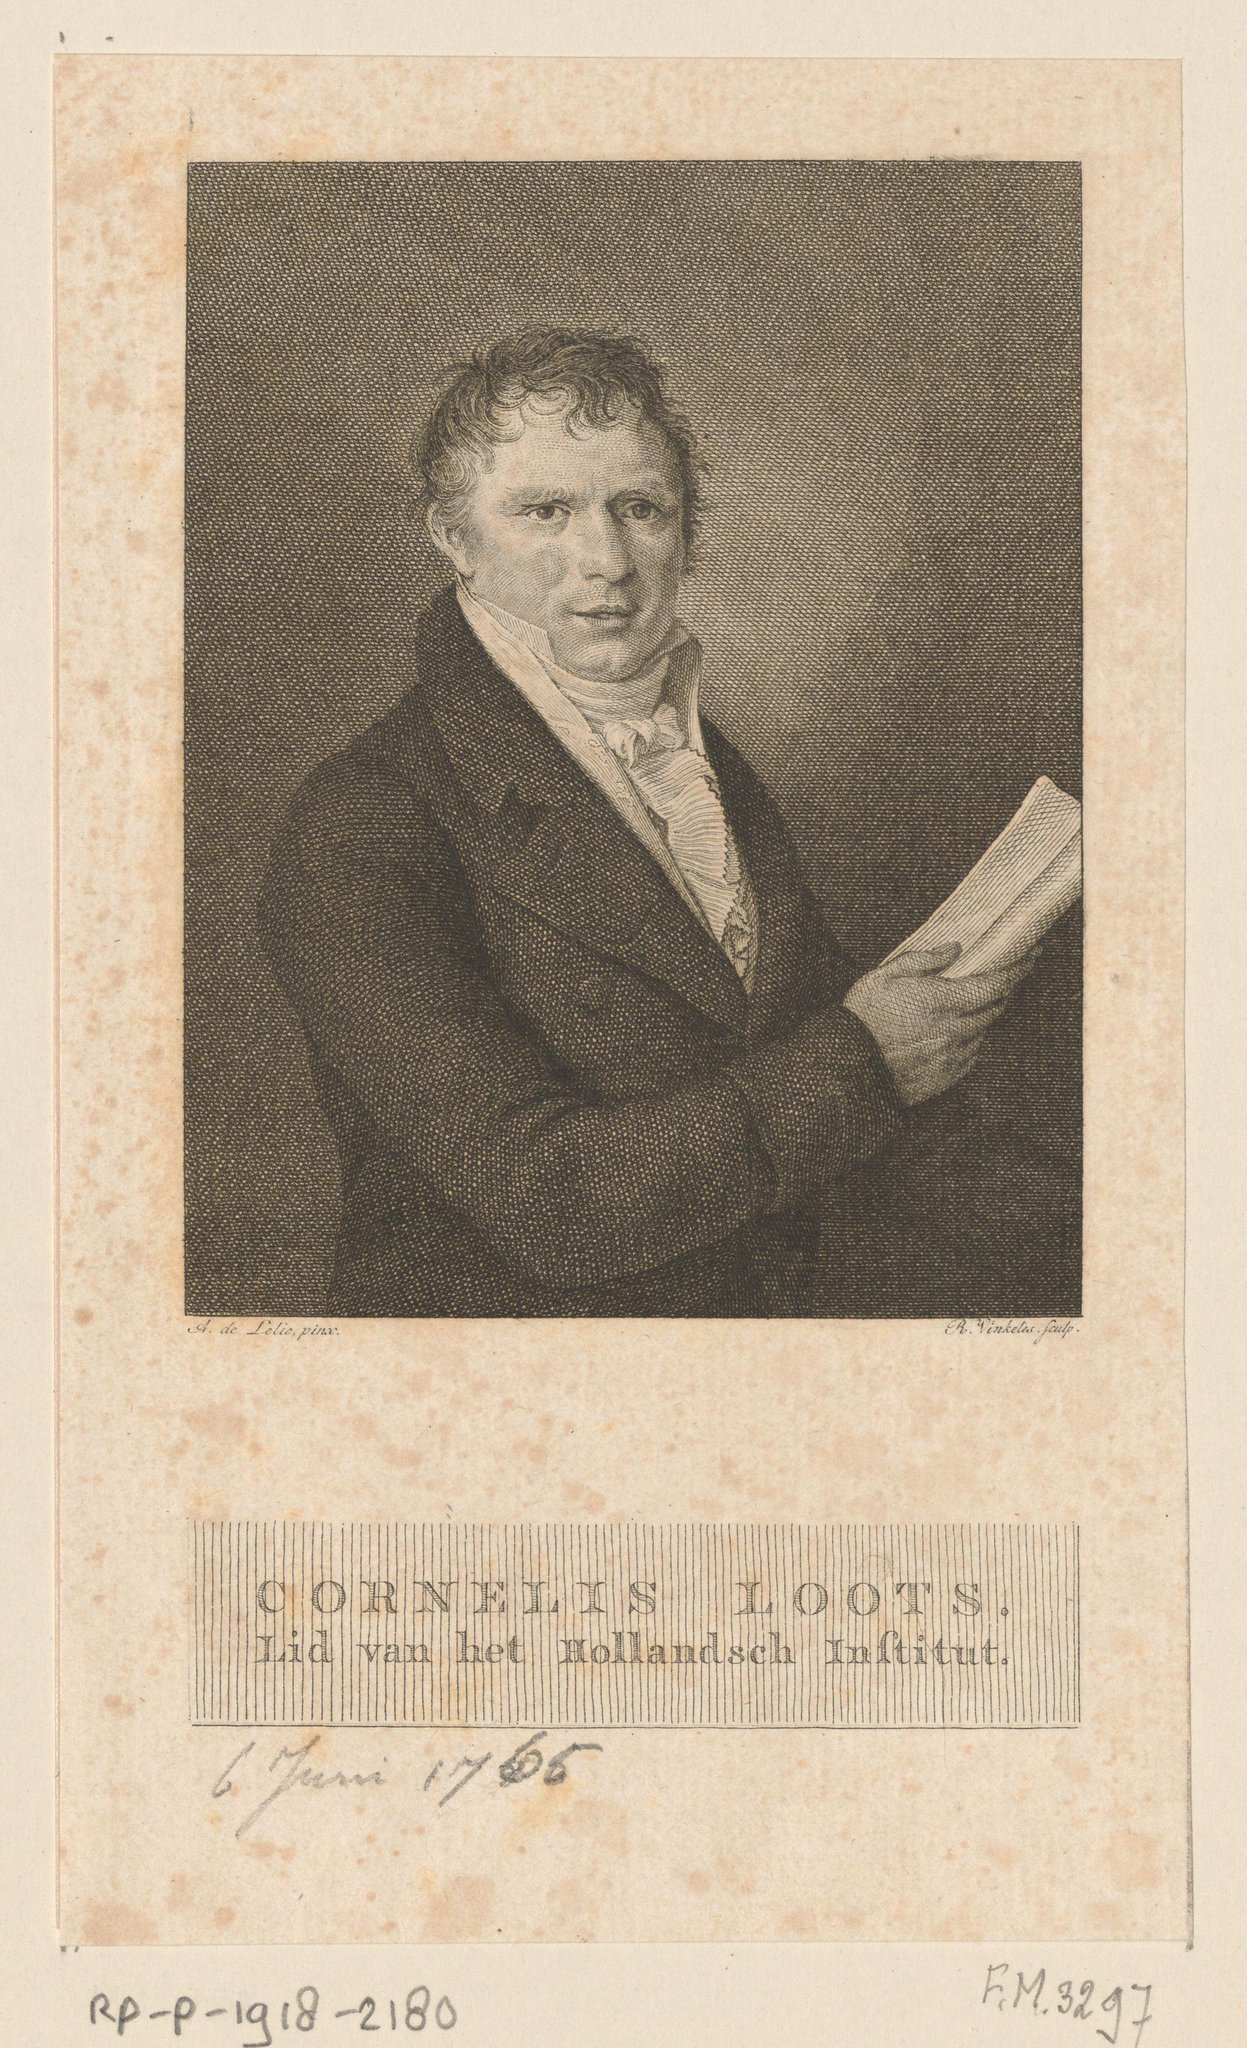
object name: print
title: Portret van Cornelis Loots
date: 1813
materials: paper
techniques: etching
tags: cornelis loots, historical persons, portrait of a writer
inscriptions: collector's mark: Lugt 2233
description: Prent waarschijnlijk uit: Loots, Cornelis. Dichtstuk ter gelegenheid van het tweede eeuwgetijde der beurs van Amsterdam. Amsterdam: J. Ruys, 1813.